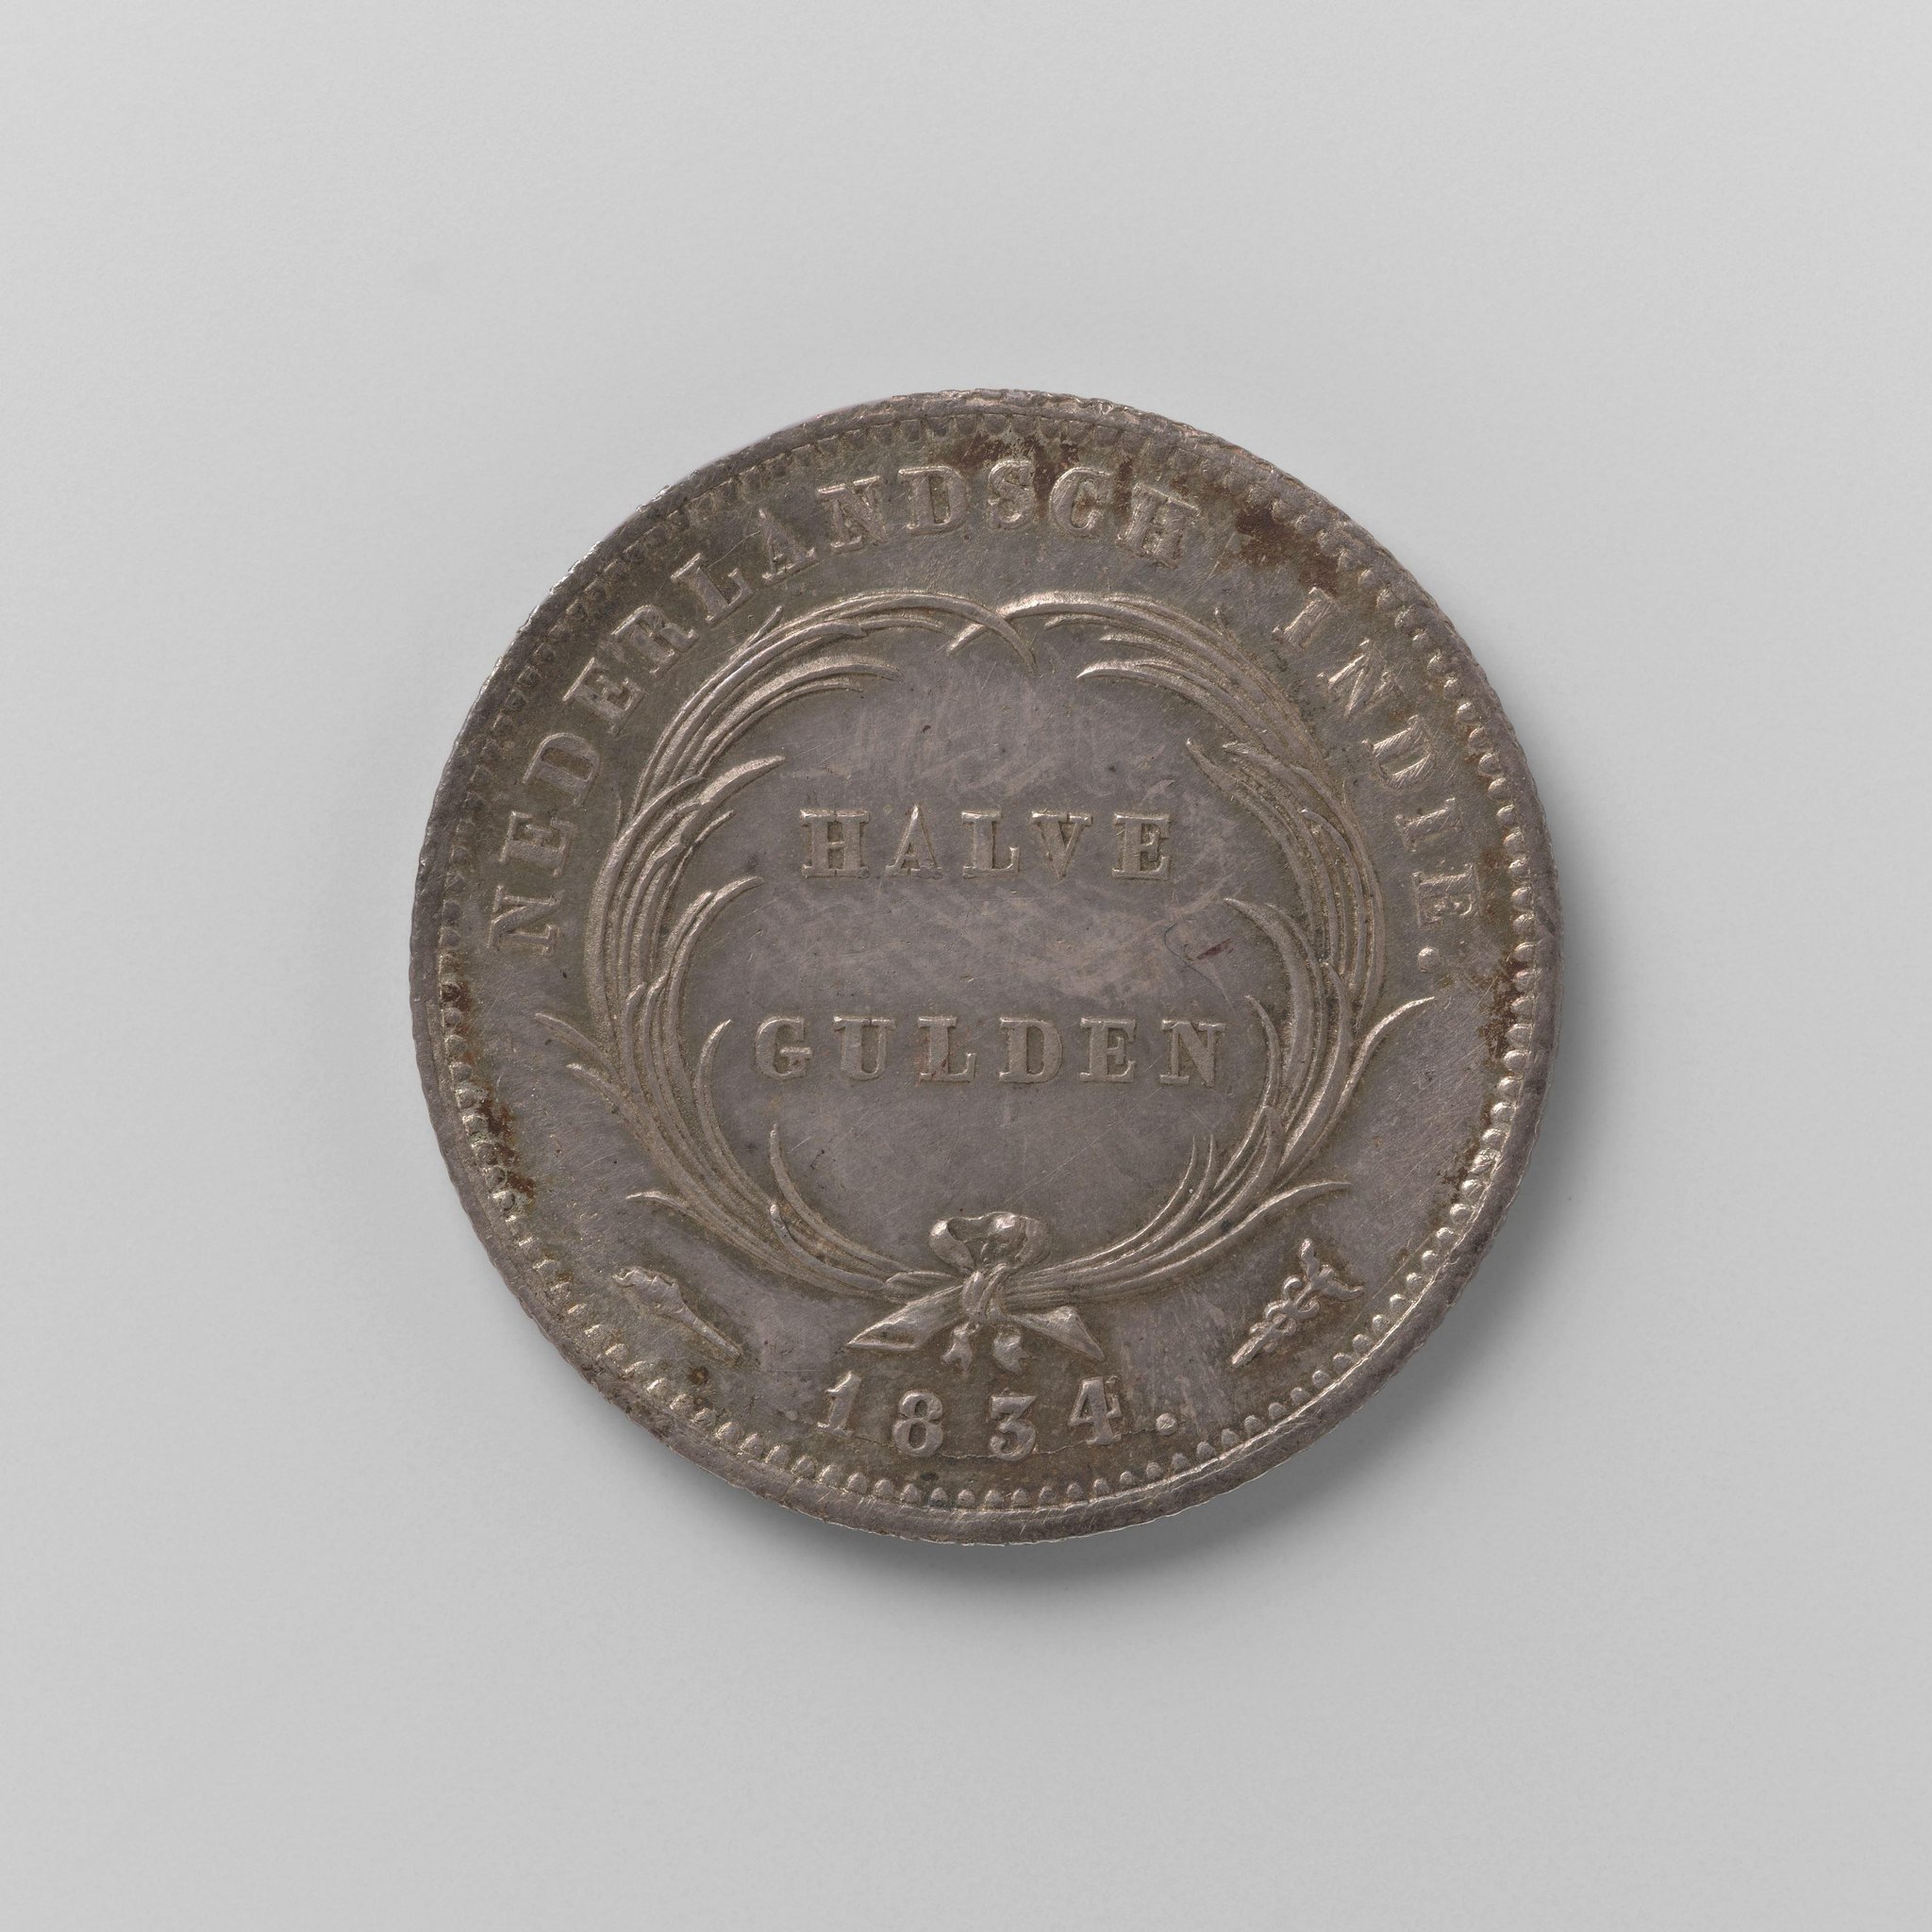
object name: coin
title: Nederlands Indië, ½ gulden, 1834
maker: william i of the netherlands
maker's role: koning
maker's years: 1772-1843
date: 1834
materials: silver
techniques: striking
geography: utrecht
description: Zilveren munt. Voorzijde: borstbeeld naar rechts. Keerzijde: tussen twee samengebonden palmtakken waarde-aanduiding. Jaartal onderaan. Kartelrand